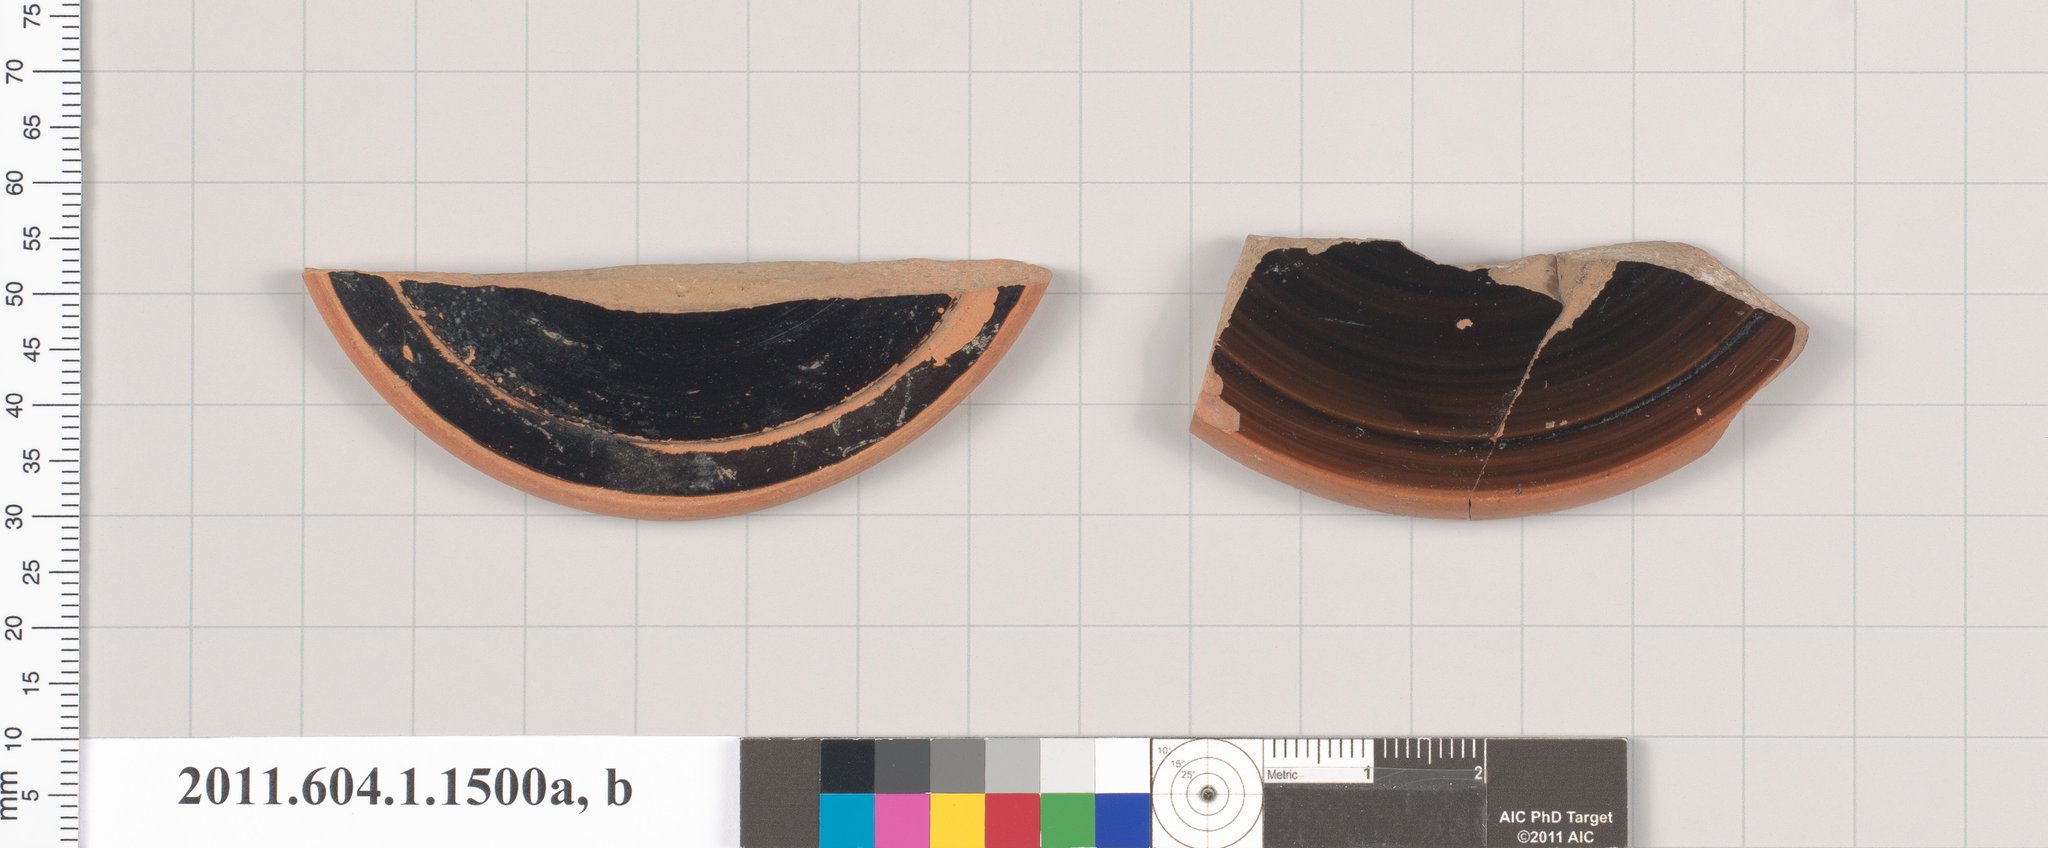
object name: kylix fragment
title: Terracotta fragments of kylikes (drinking cups)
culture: greek, attic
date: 500-401 BCE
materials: terracotta